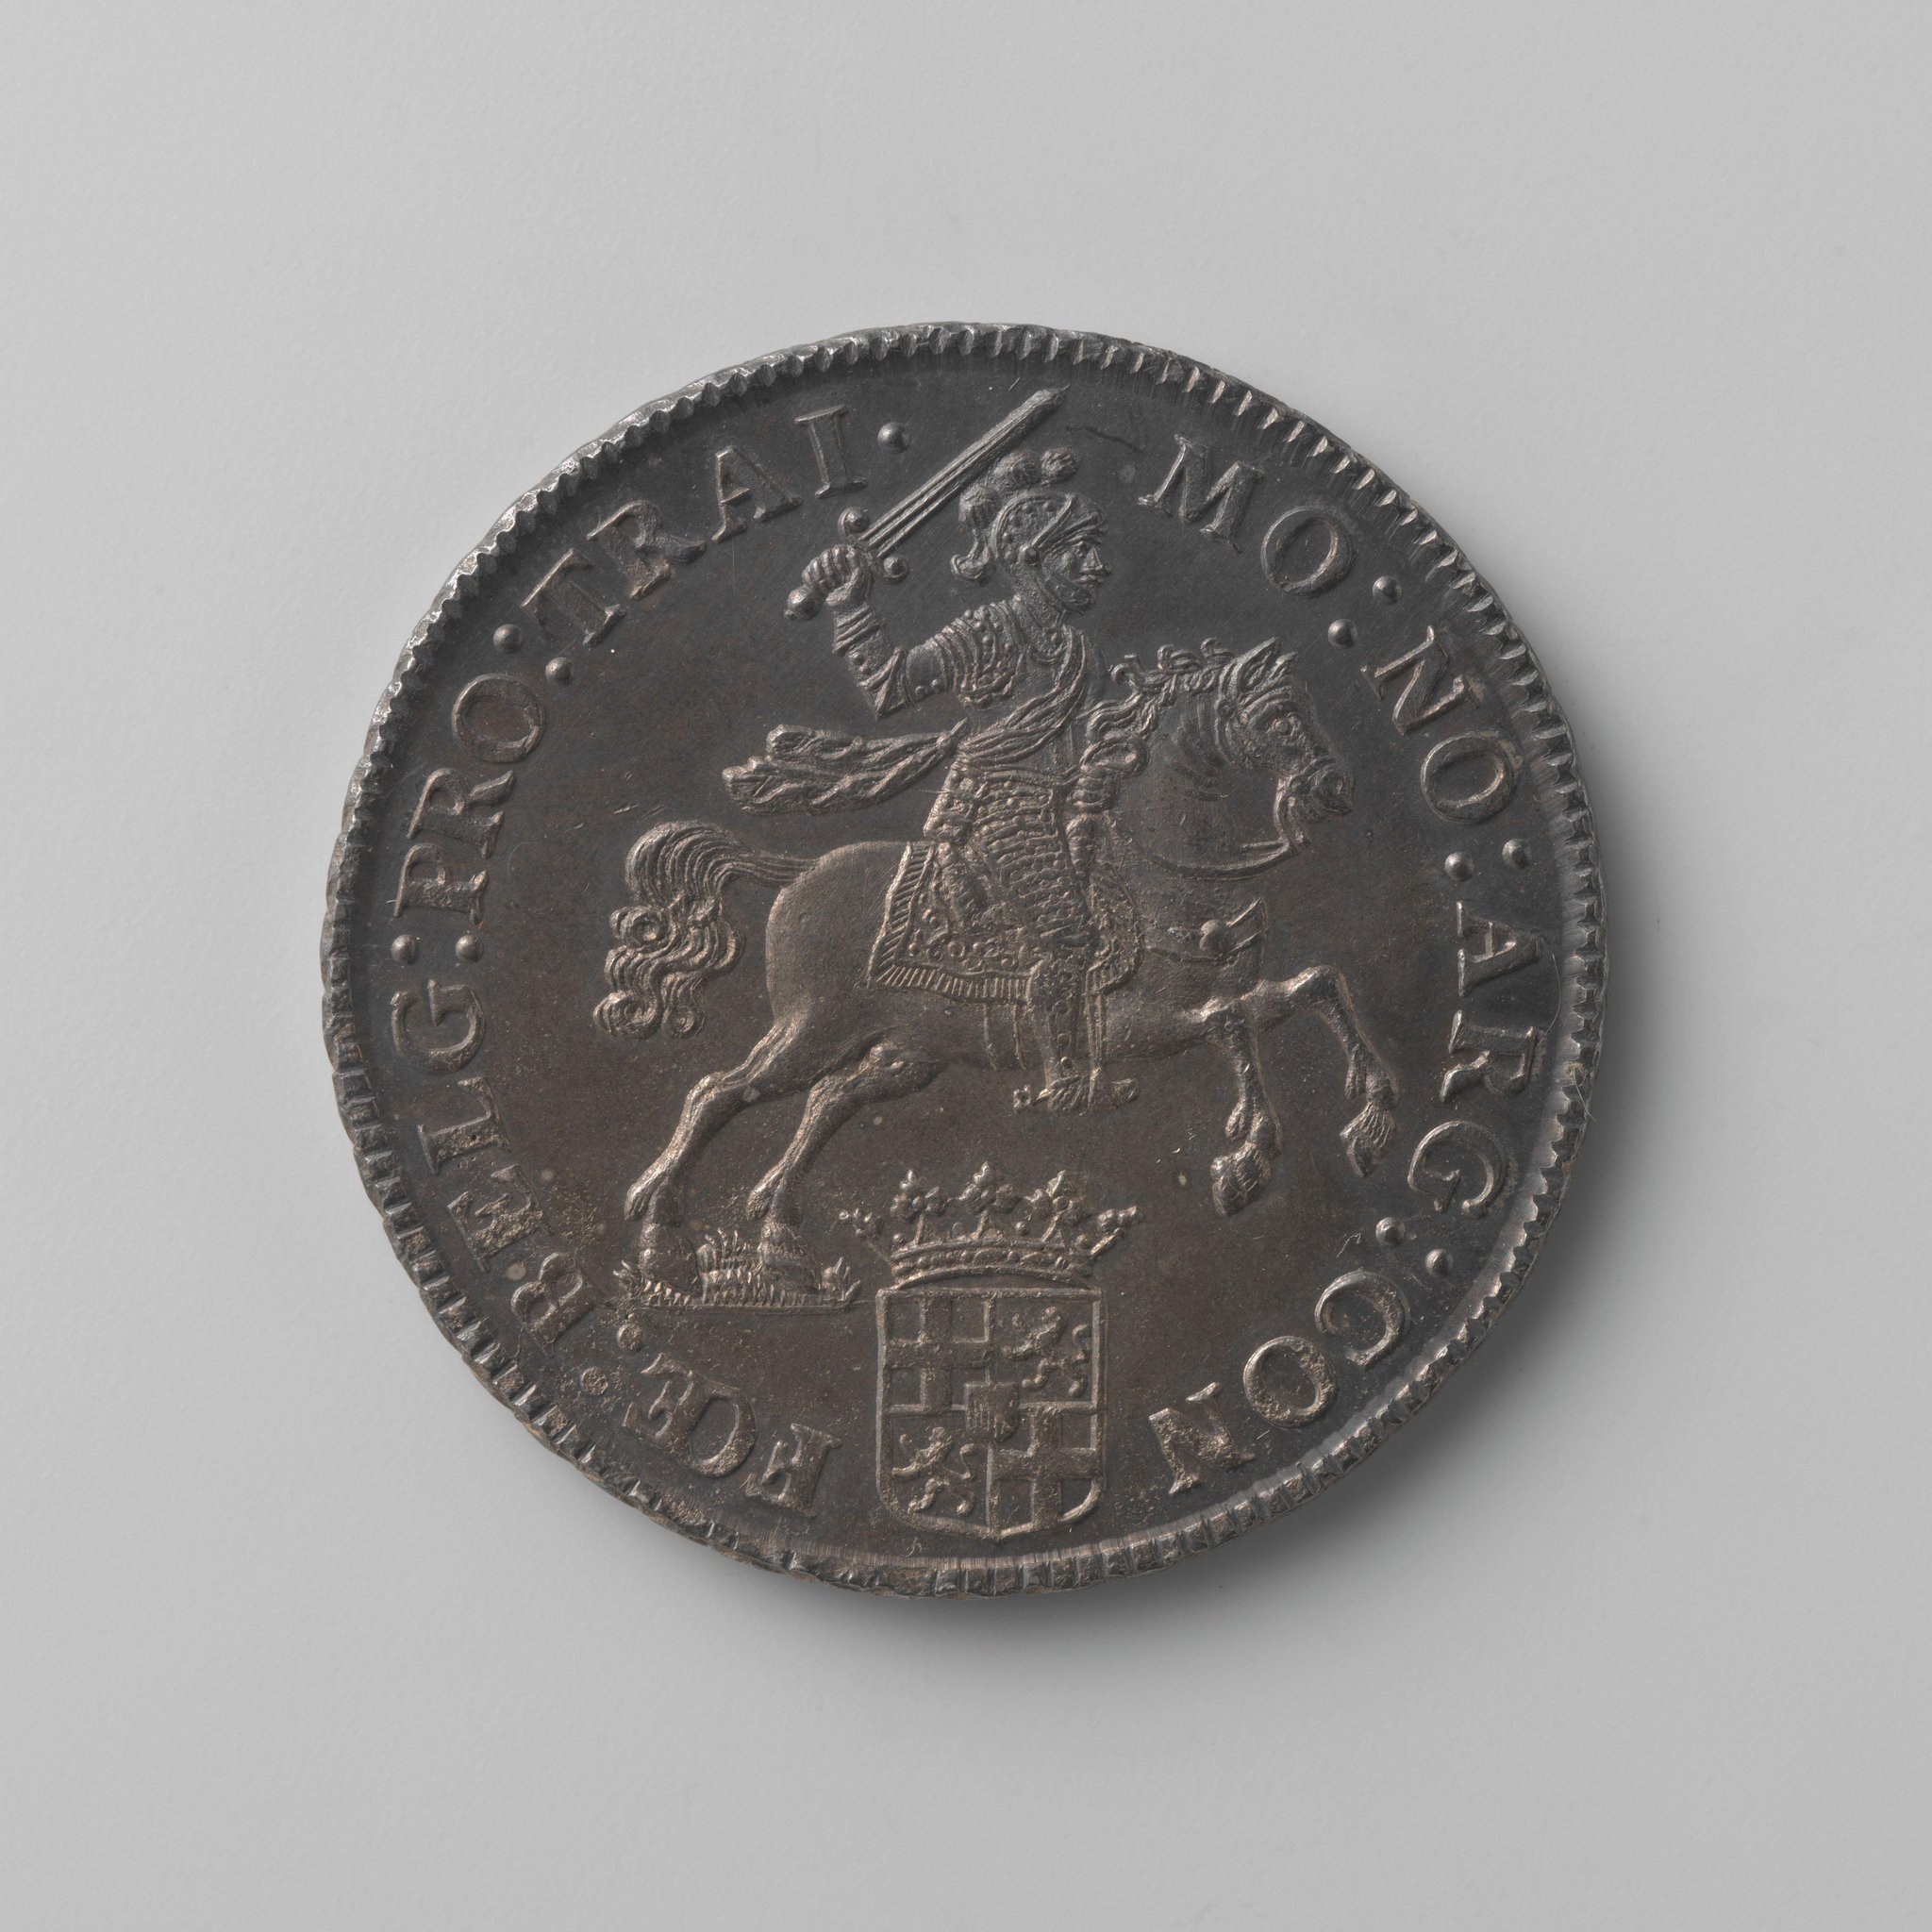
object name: coin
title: Utrecht, zilveren rijder, 1749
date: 1749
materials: silver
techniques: striking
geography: utrecht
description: Zilveren munt. Voorzijde: ridder te paard naar rechts met in rechterhand zwaard. Onder paard gekroond wapenschild van Utrecht. Keerzijde: door twee gekroonde leeuwen gehouden generaliteitswapenschild. Daaronder in cartouche jaartal. Bloemrand.